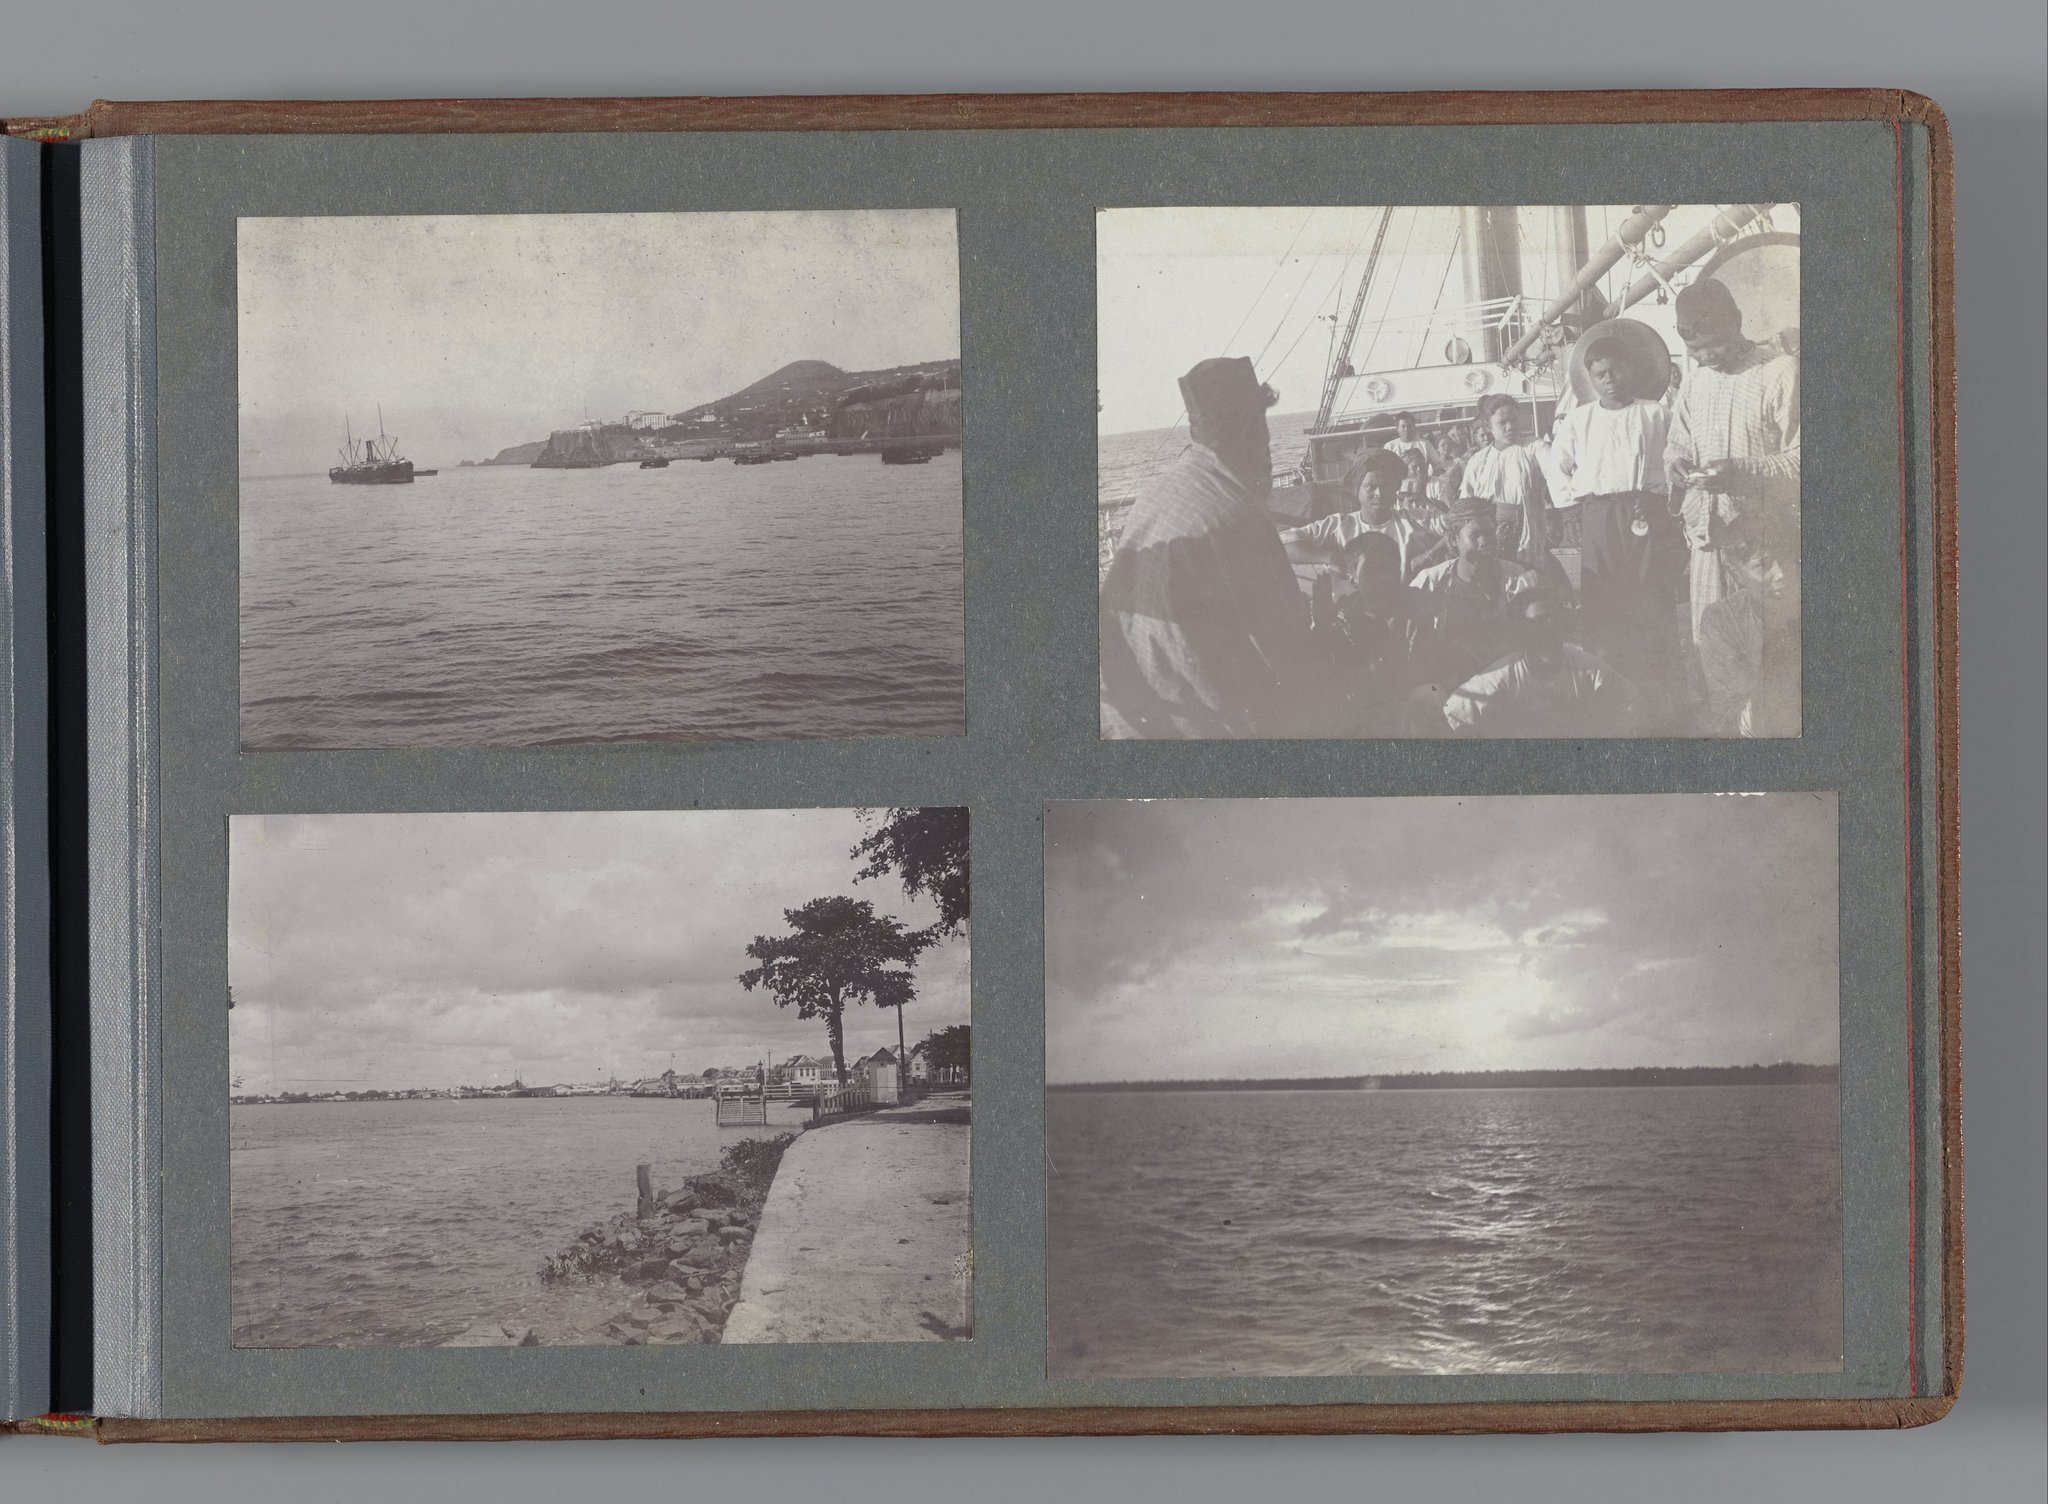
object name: photograph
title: Kustlijn van Paramaribo (?)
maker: Anonymous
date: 1905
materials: cardboard, paper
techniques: photography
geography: paramaribo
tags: paramaribo (stad)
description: Kustlijn van Paramaribo (?). Onderdeel van fotoalbum 'Suriname'.